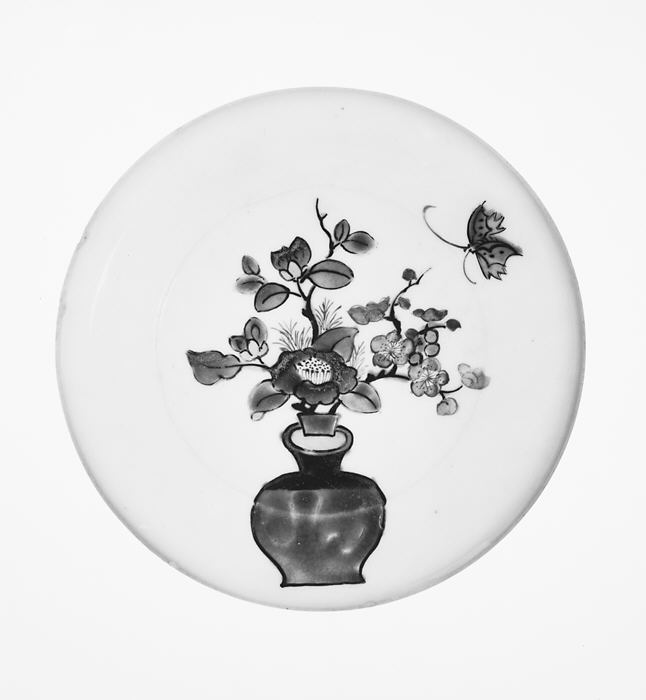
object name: dish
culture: japanese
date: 1615-1868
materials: enamel, porcelain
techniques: painting, polychrome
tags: butterflies,flowers